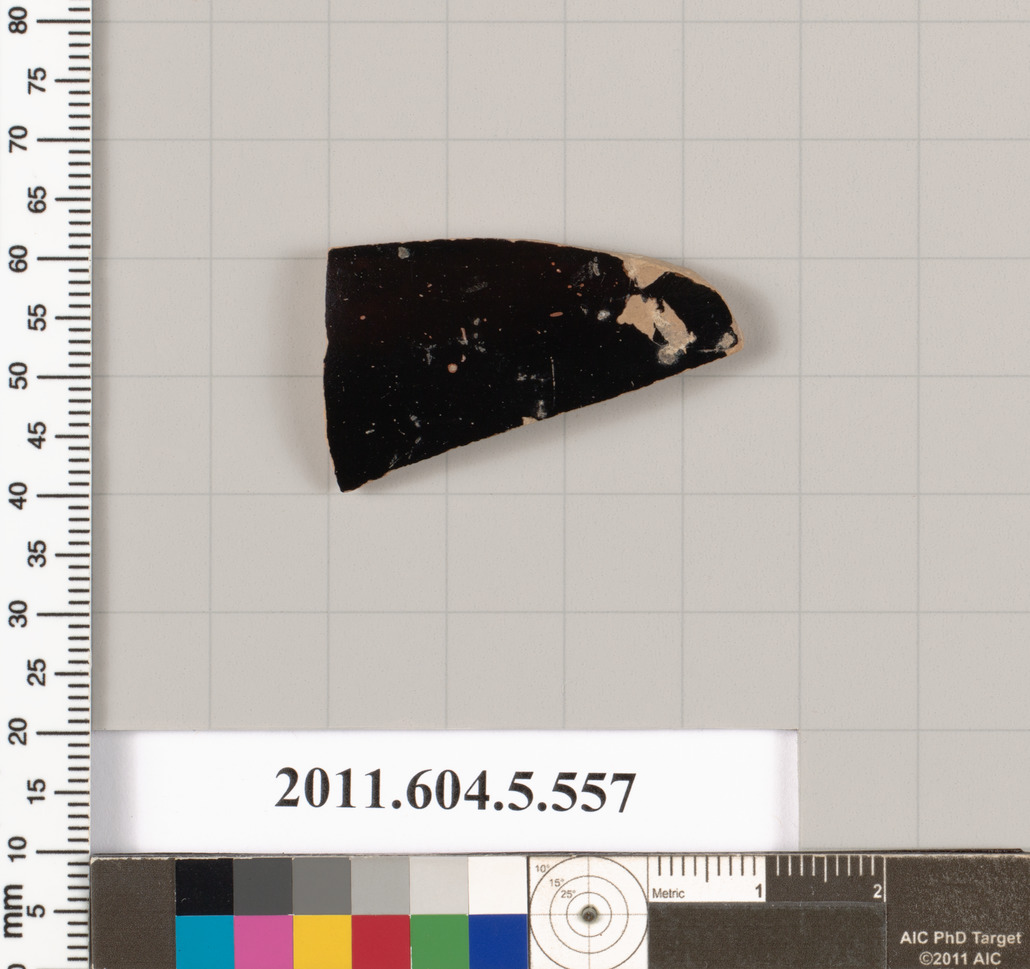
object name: kylix fragment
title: Terracotta fragment of a kylix (drinking cup)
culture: greek, attic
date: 600-401 BCE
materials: terracotta